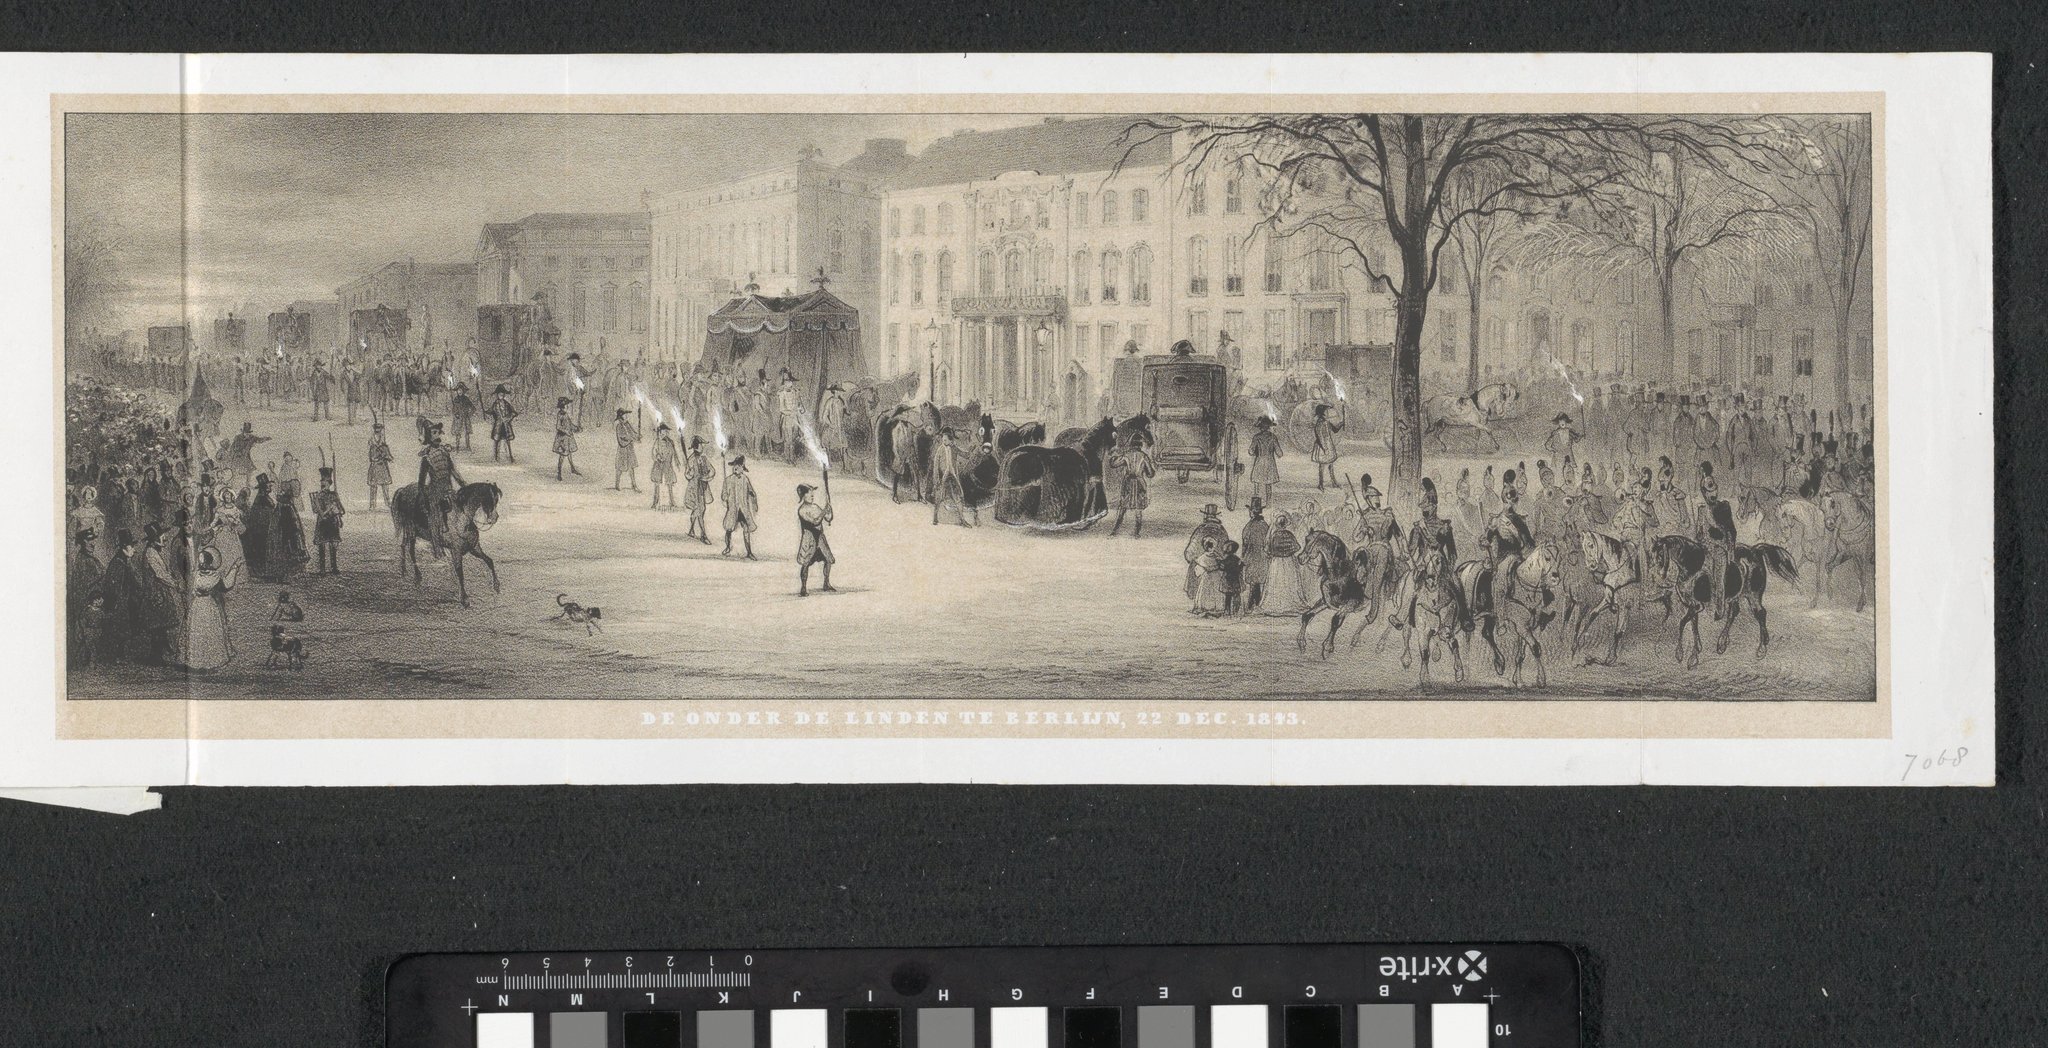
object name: print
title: De Onder de Linden te Berlijn, 22 Dec. 1843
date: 1844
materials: paper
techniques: lithograph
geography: netherlands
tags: the hague, berlin, william i of the netherlands, vigils and wakes ~ burial rites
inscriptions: collector's mark: Lugt 2228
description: Lijkstoet met de lijkkist van de voormalige koning Willem I bij het Altes Palais, het paleis aan de Onder de Linden (Unter den Linden) te Berlijn, 22 december 1843. In de beschrijving een lijst van de wagens en inzittenden in de stoet. Tweed plaat in het boekje met twee platen van het overlijden van de voormalige koning Willem I in Berlijn, 22 december 1843. Dit boekje verscheen als supplement op een groter werk met meer platen uit 1844.